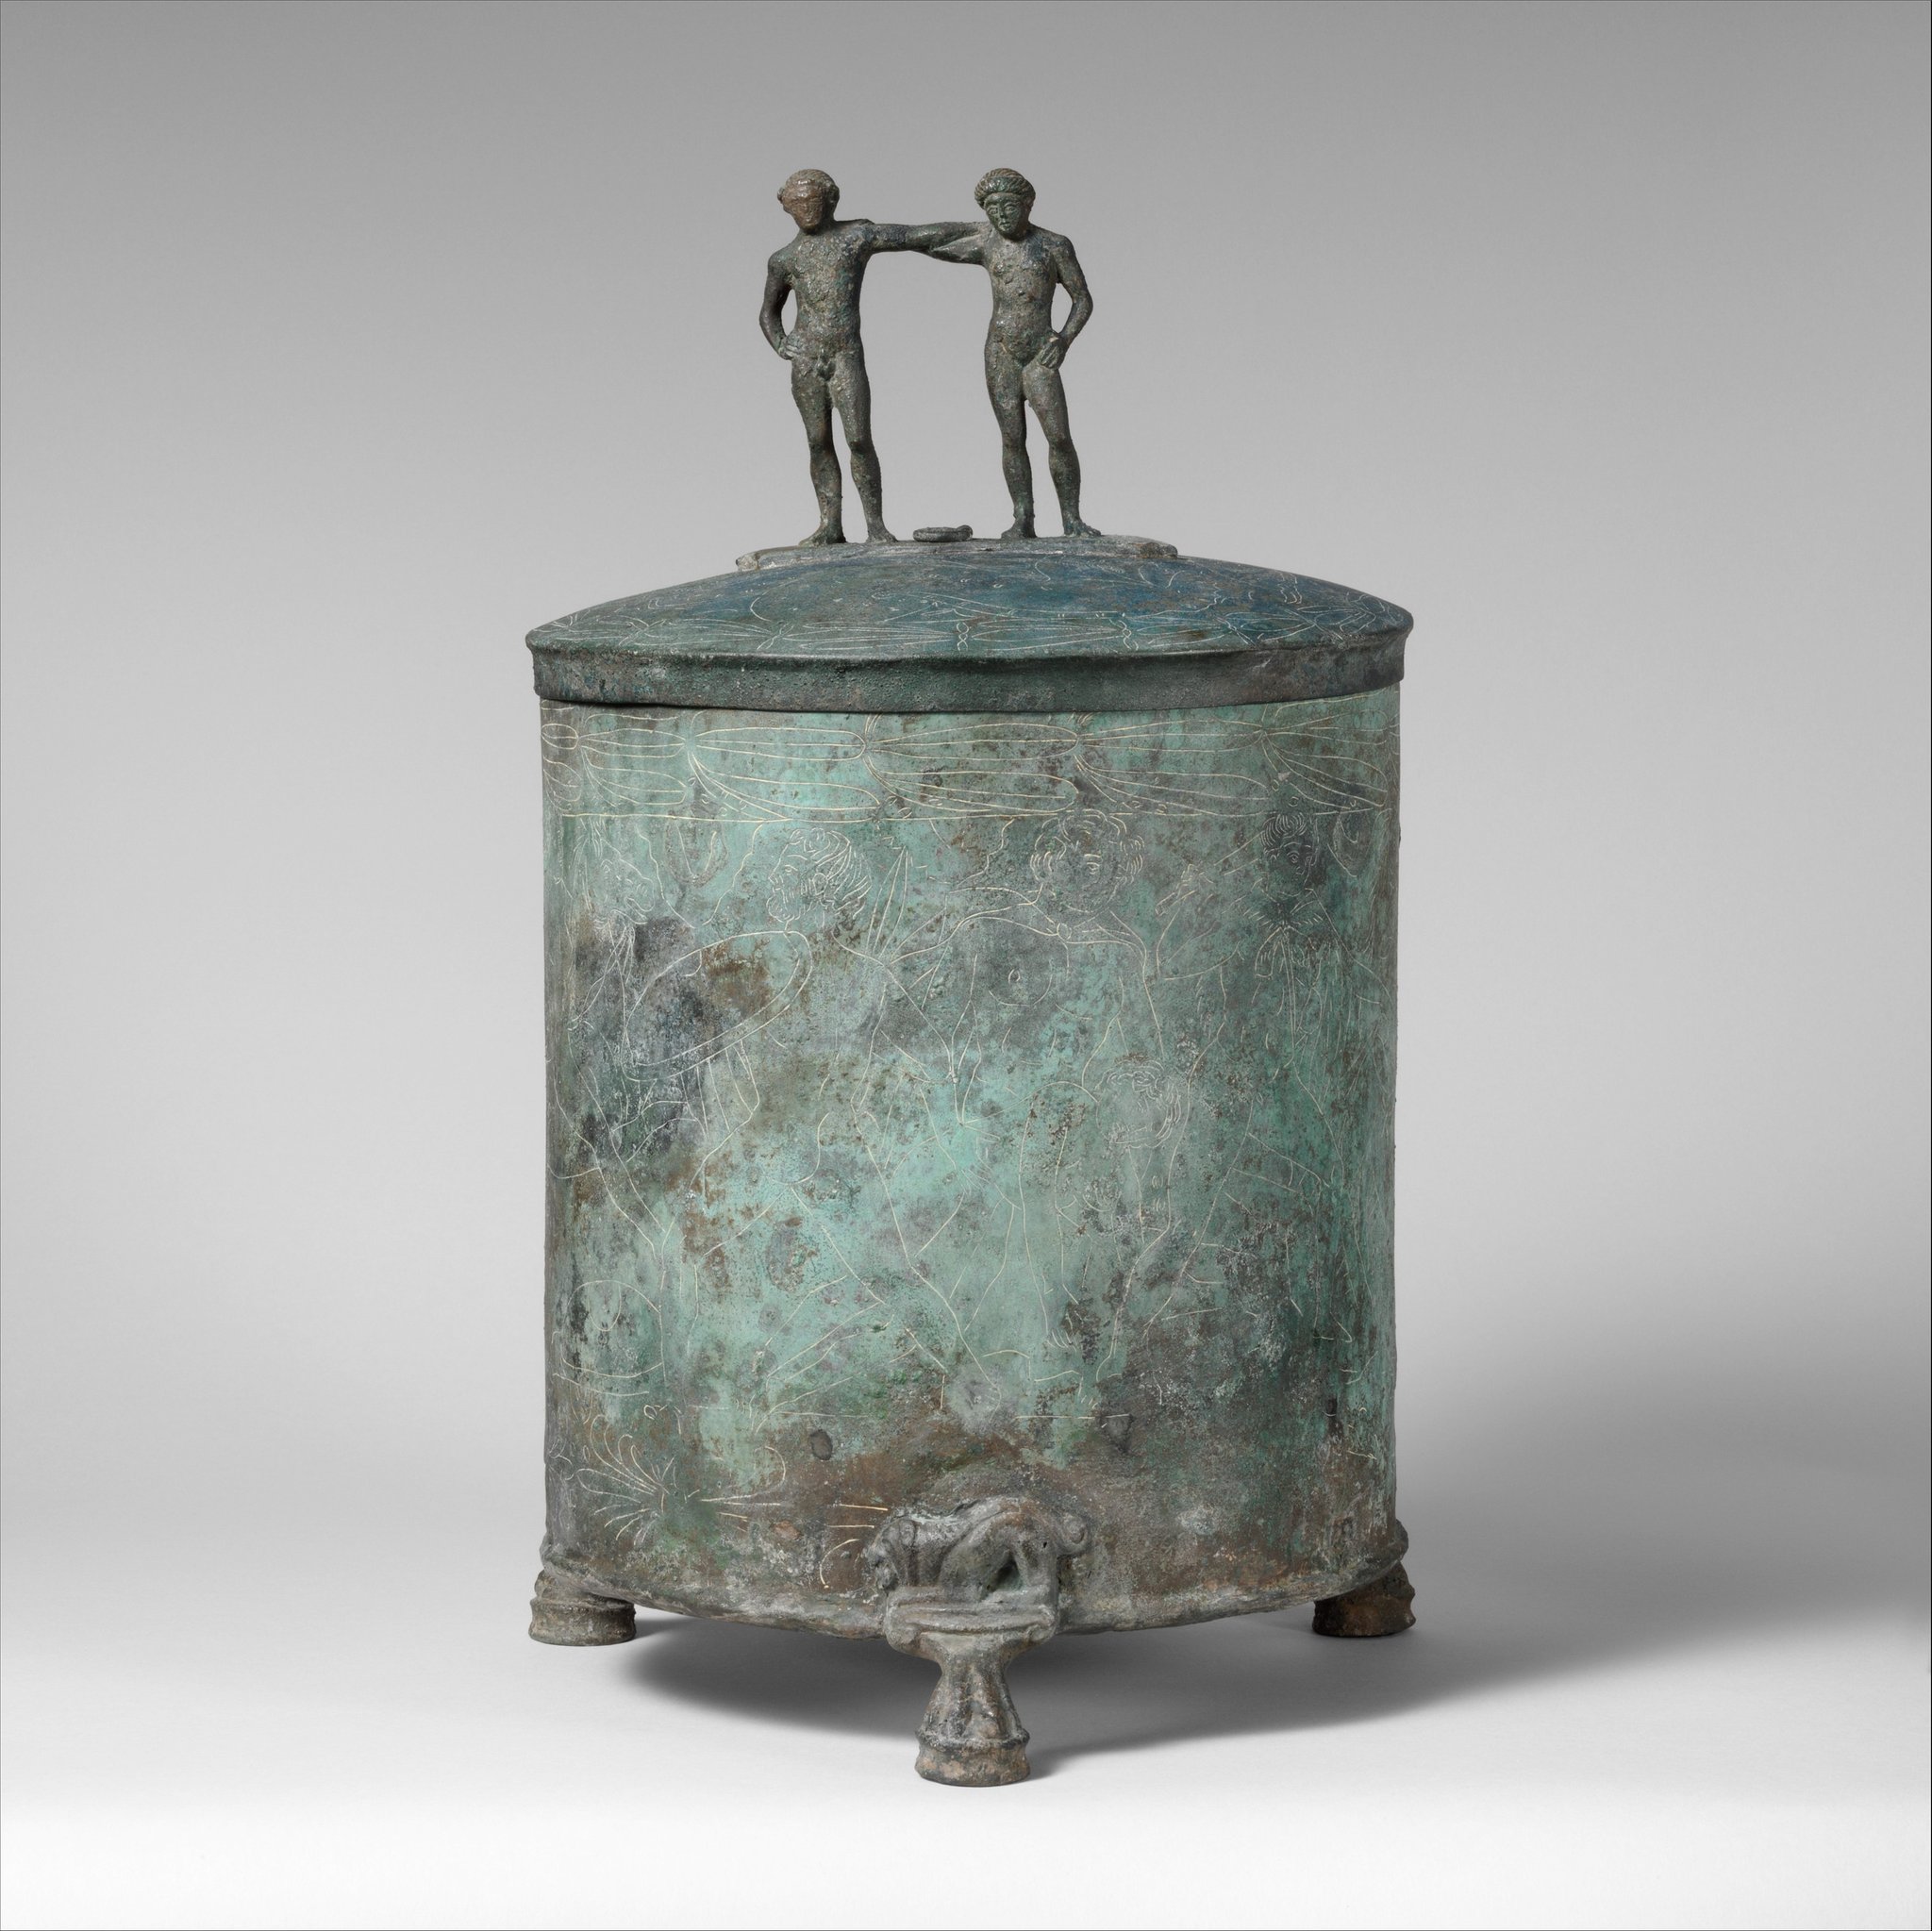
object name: cista with lid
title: Bronze cista (toiletries box)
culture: praenestine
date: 325-275 BCE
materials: bronze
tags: animals,male nudes,female nudes,amazons,horses,herakles